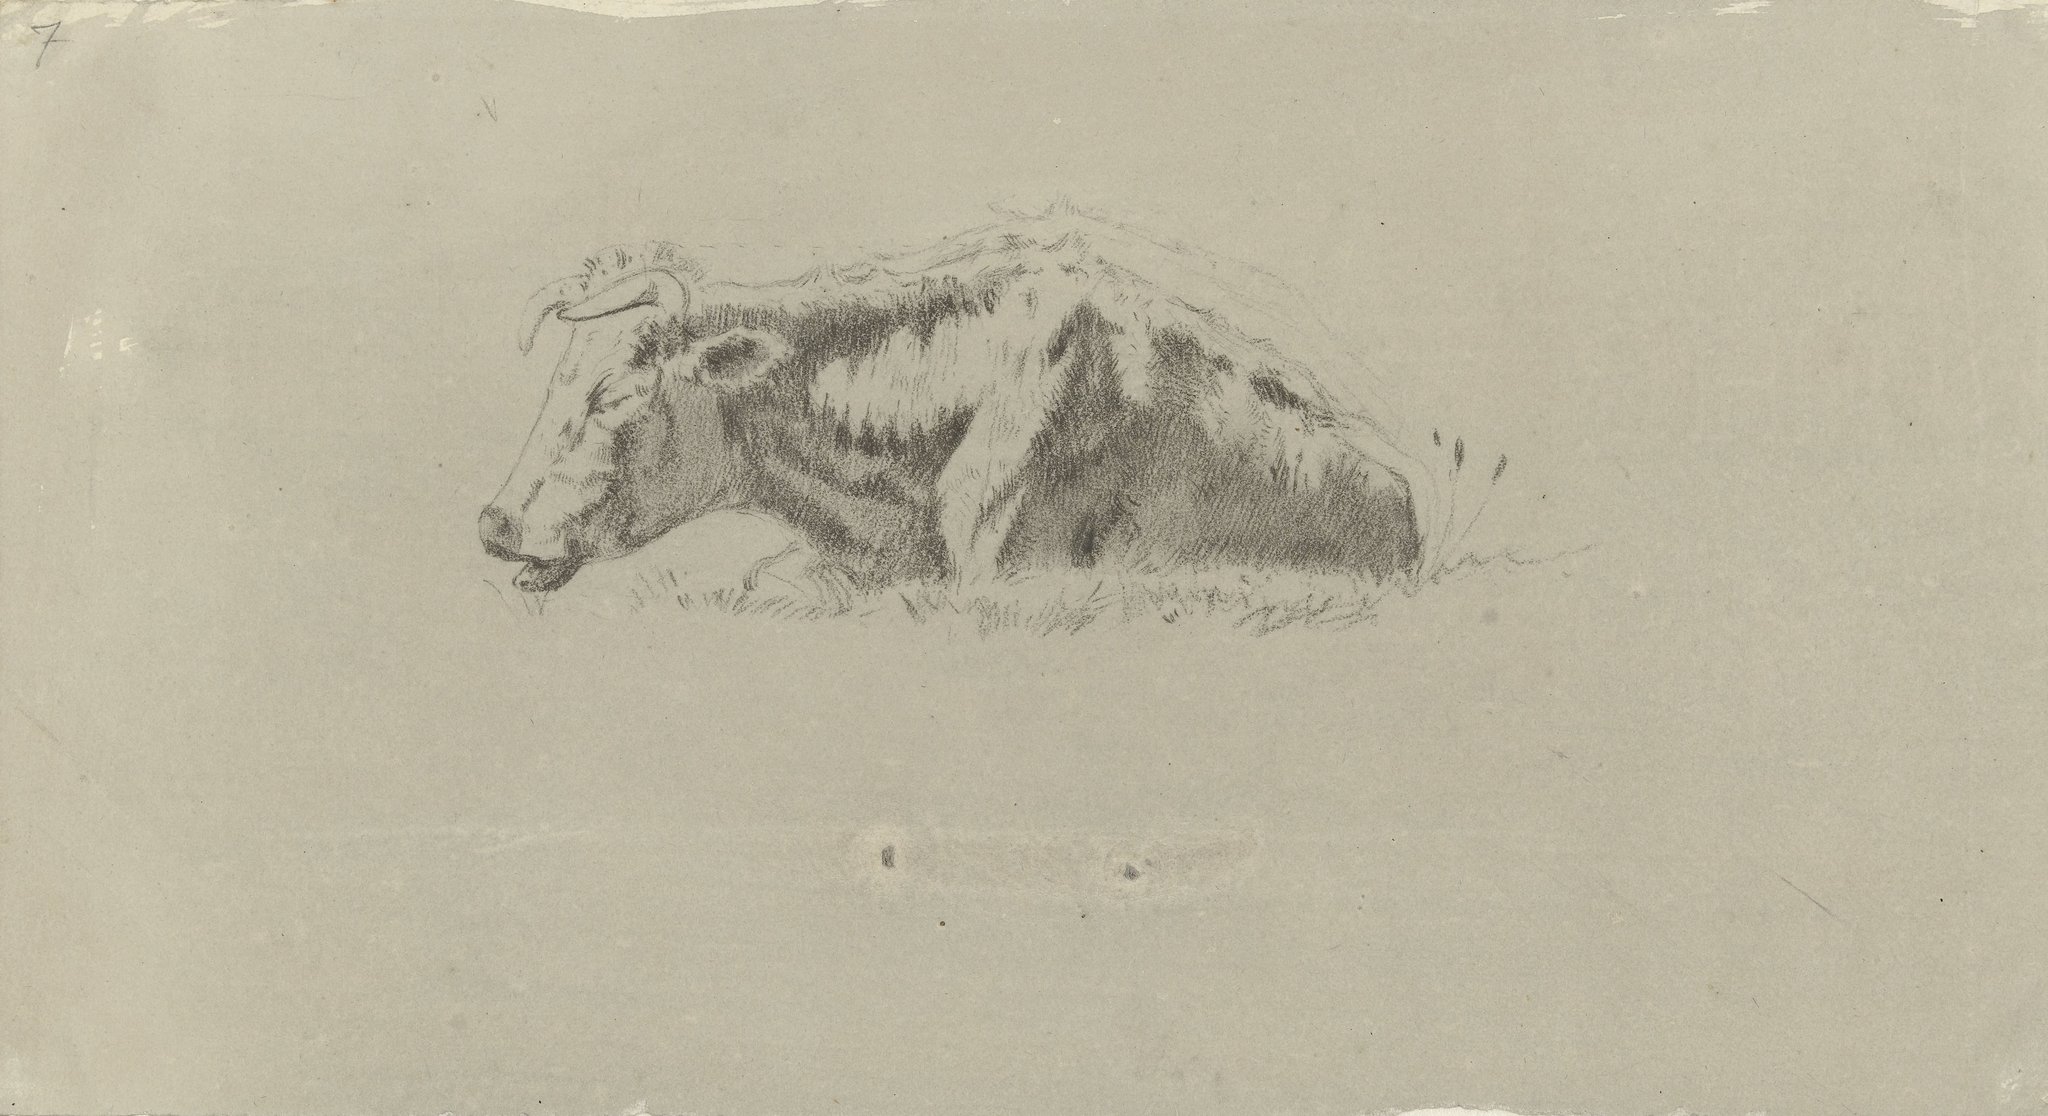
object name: drawing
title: Liggende koe, naar links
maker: gerard bilders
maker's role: draughtsman, print maker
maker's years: 1838-1865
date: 1848-1865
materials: chalk, paper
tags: cow